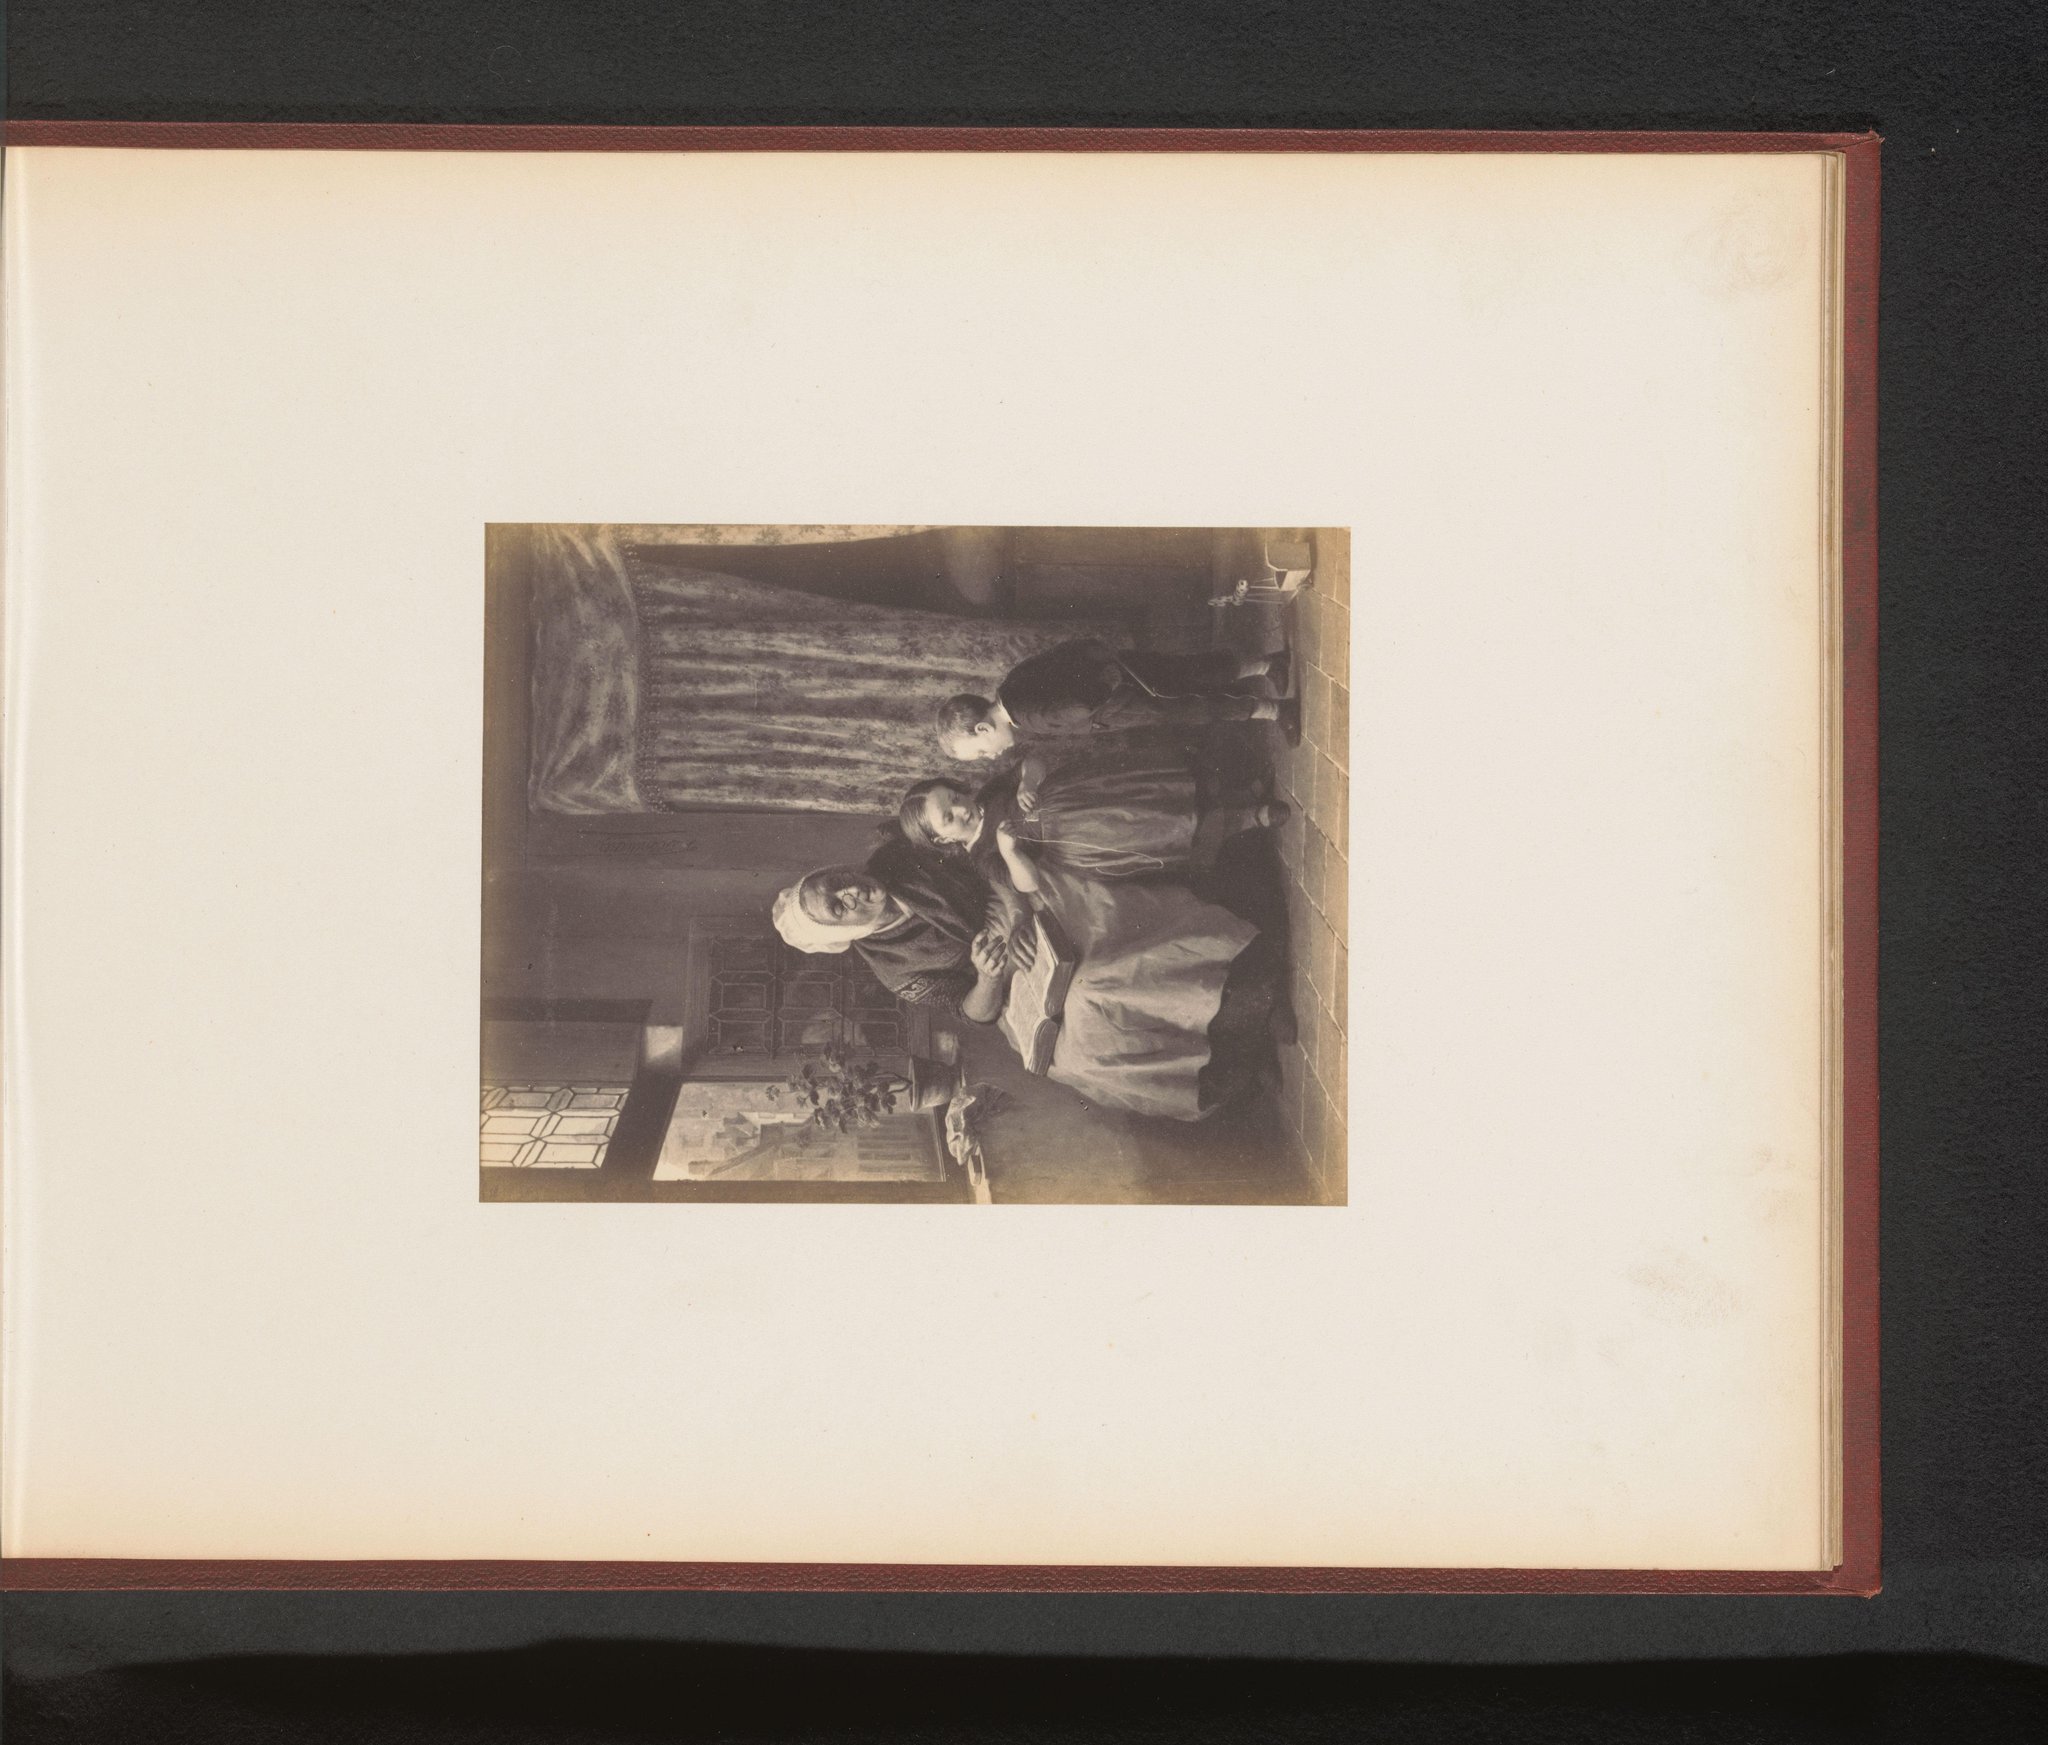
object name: reproduction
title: Fotoreproductie van La leçon sollicitée van de Bruycker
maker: Anonymous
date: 1858-1863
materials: photographic support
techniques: albumen print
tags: education, science and learning, old woman, picture, painting